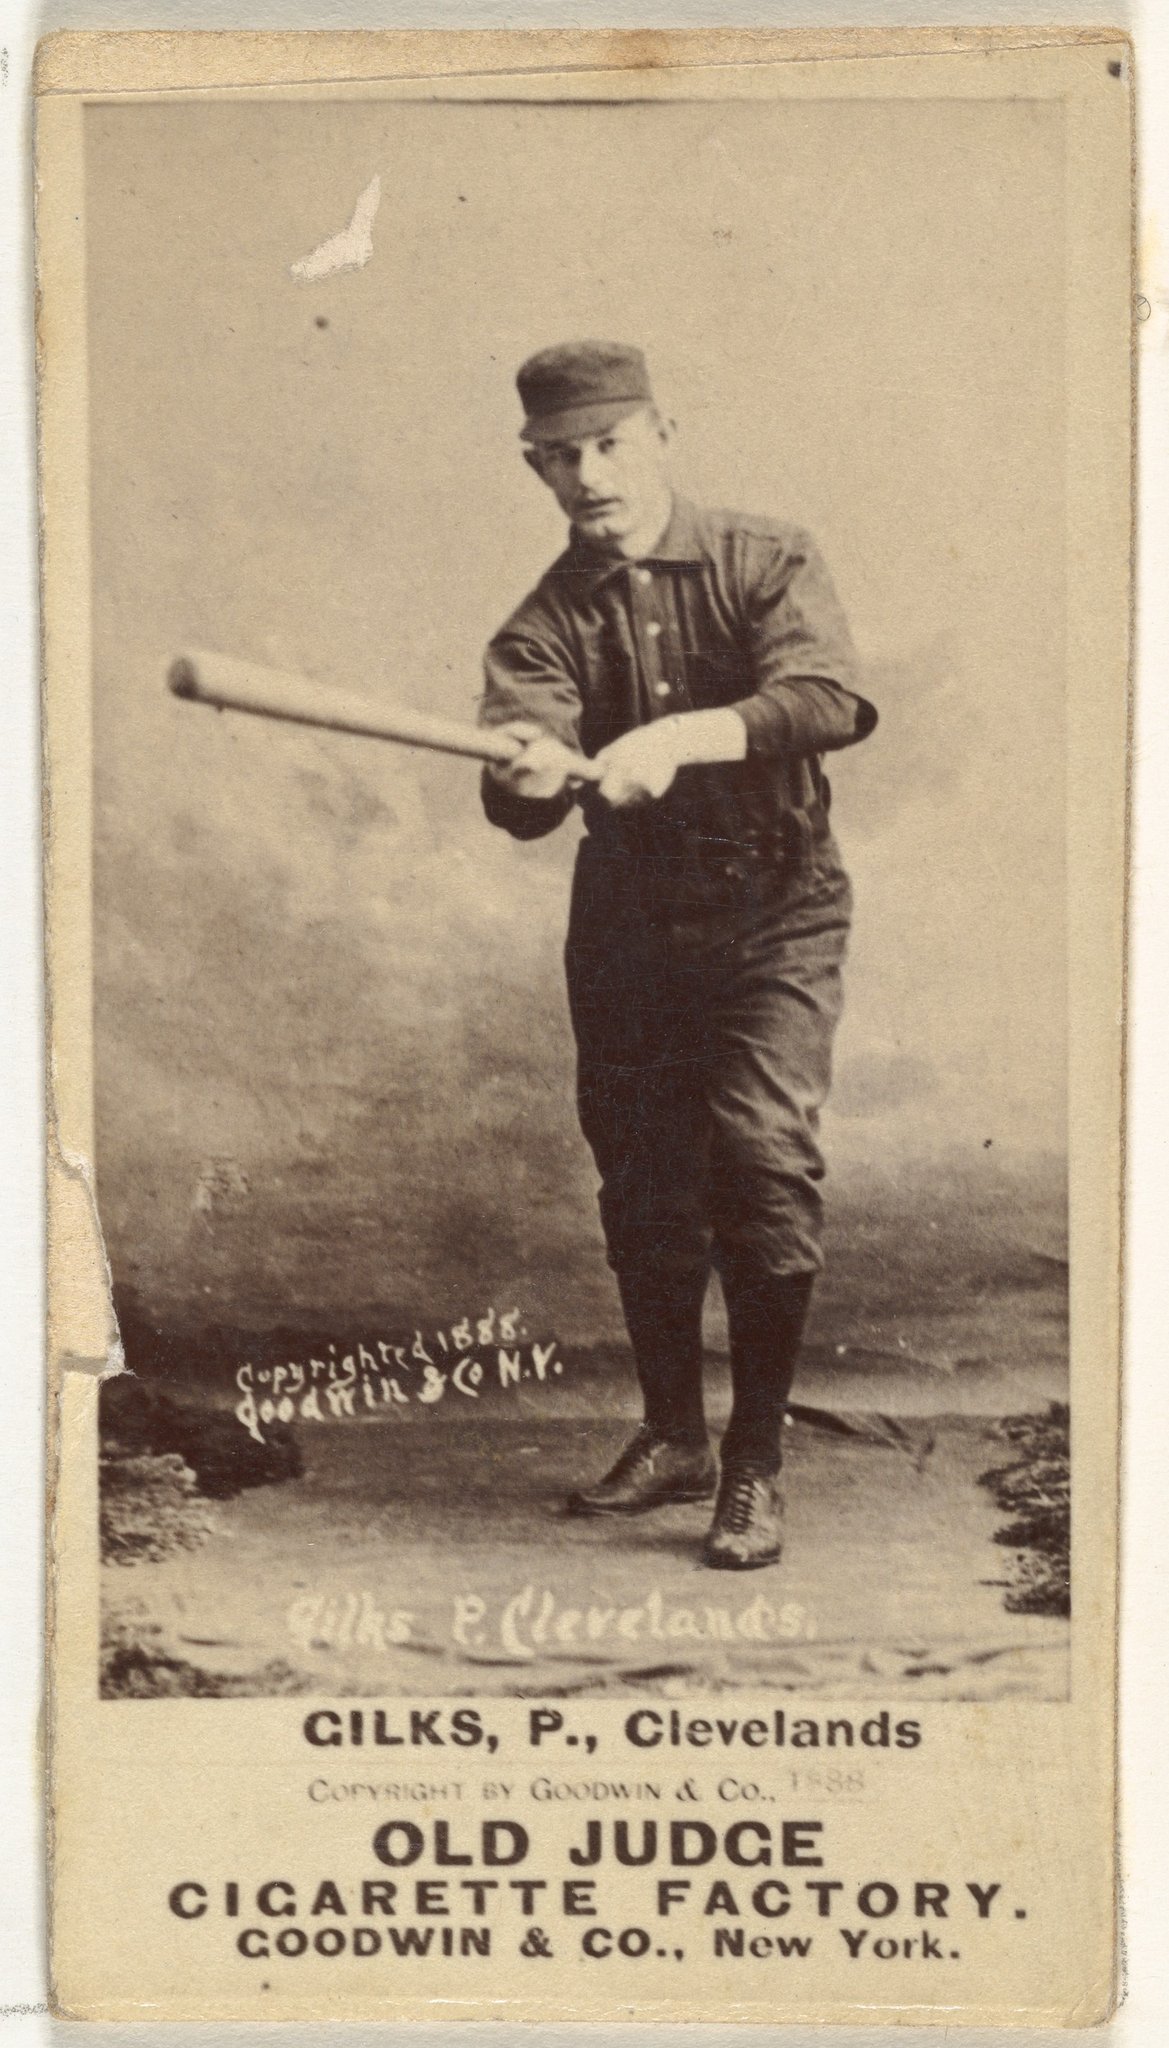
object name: baseball card, photograph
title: Robert James "Bob" Gilks, Pitcher, Cleveland, from the Old Judge series (N172) for Old Judge Cigarettes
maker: goodwin & company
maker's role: publisher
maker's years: 1850-1950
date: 1888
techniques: albumen silver print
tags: men,portraits,baseball,athletes